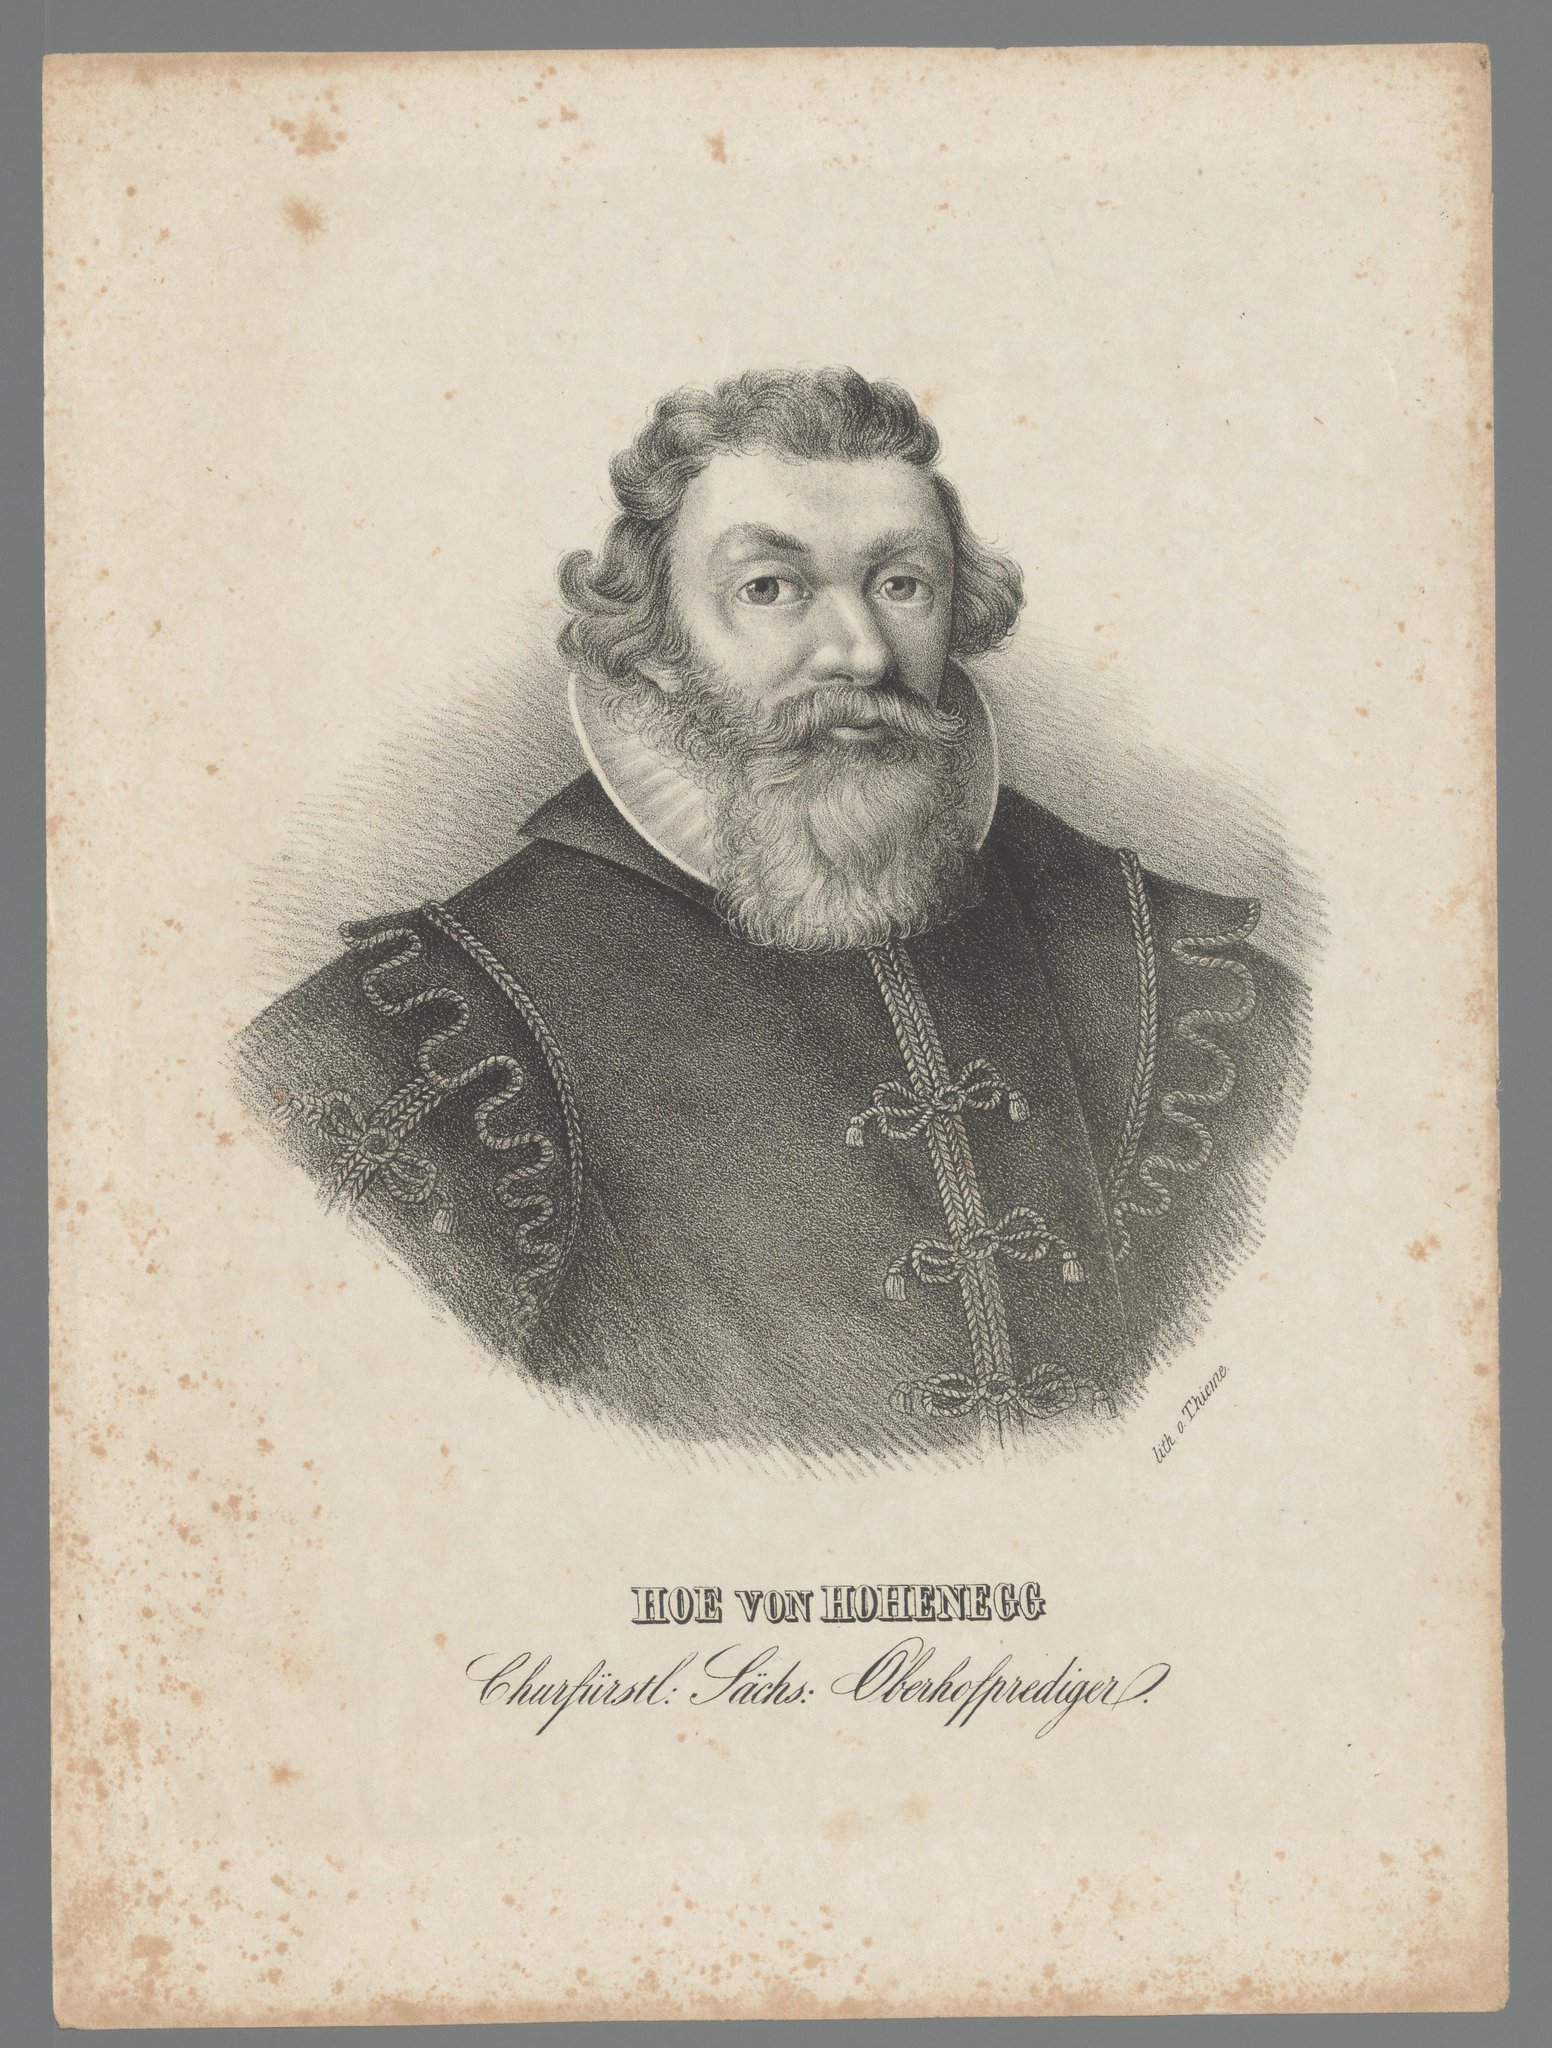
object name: print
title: Hoe von Hohenegg, Churfürst. Sächs. Oberhofprediger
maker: theodor thieme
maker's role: print maker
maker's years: 1823-1901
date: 1833-1901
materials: paper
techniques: lithograph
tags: adult man, historical persons, beard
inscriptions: collector's mark: Lugt 2228